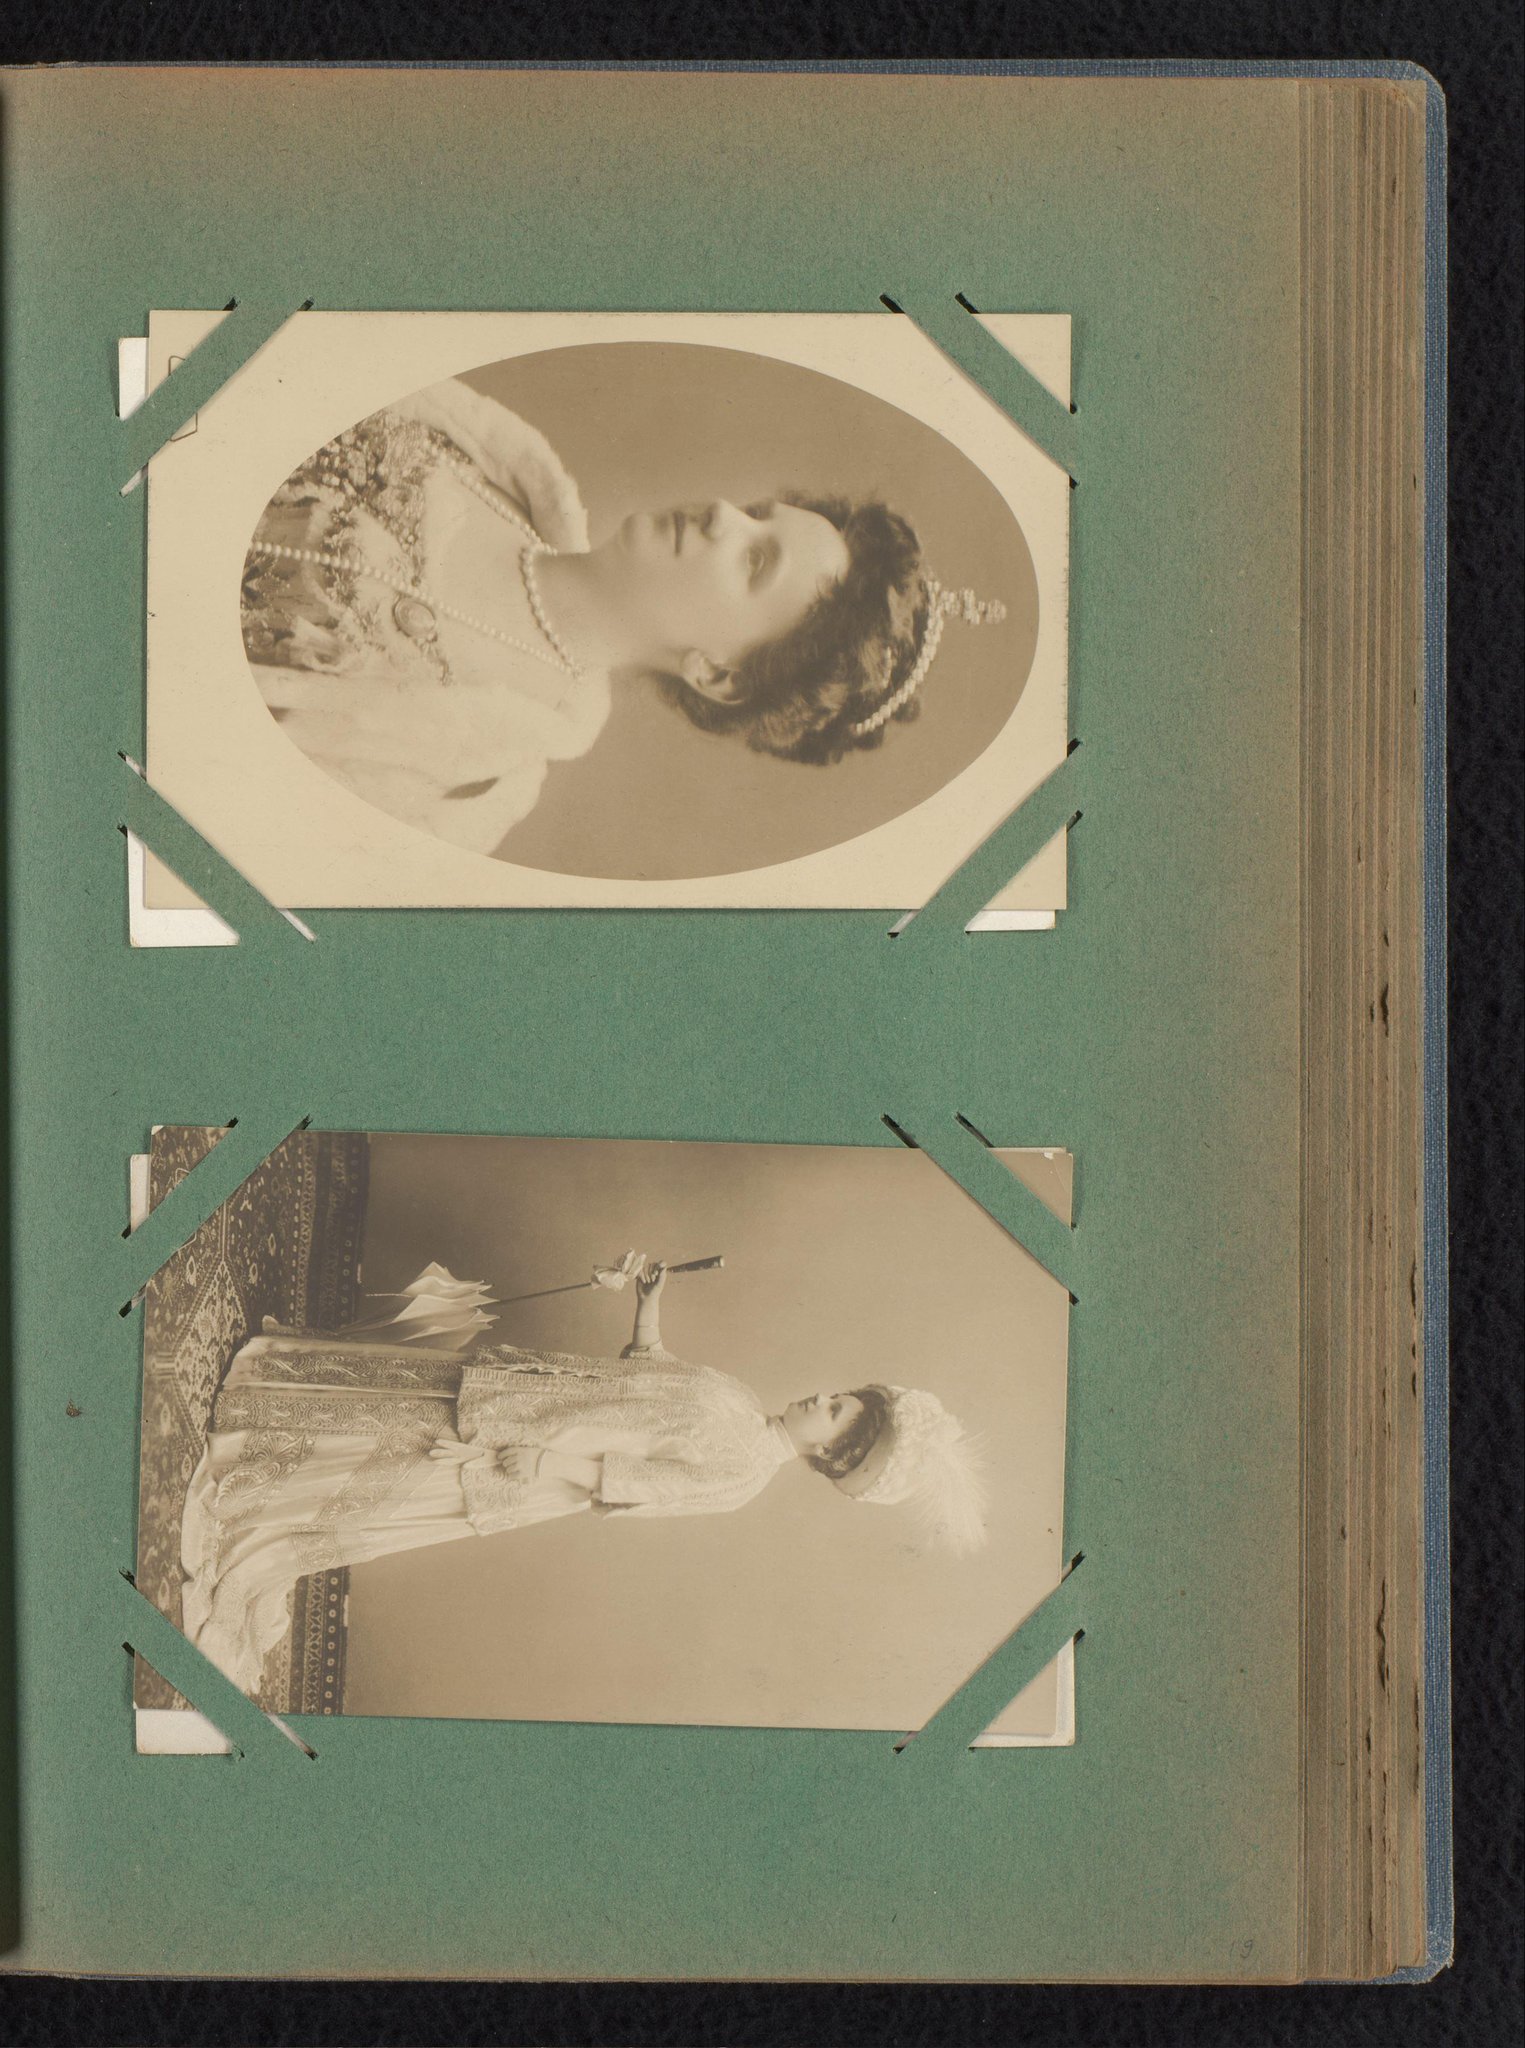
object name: ansichtkaart, prentbriefkaart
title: Twee prentbriefkaarten met portretten van koningin Wilhelmina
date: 1908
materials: paper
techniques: gelatin silver print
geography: netherlands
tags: print maker, wilhelmina of the netherlands, historical persons - bb - woman, queen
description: Deze foto's maken deel uit van een album.